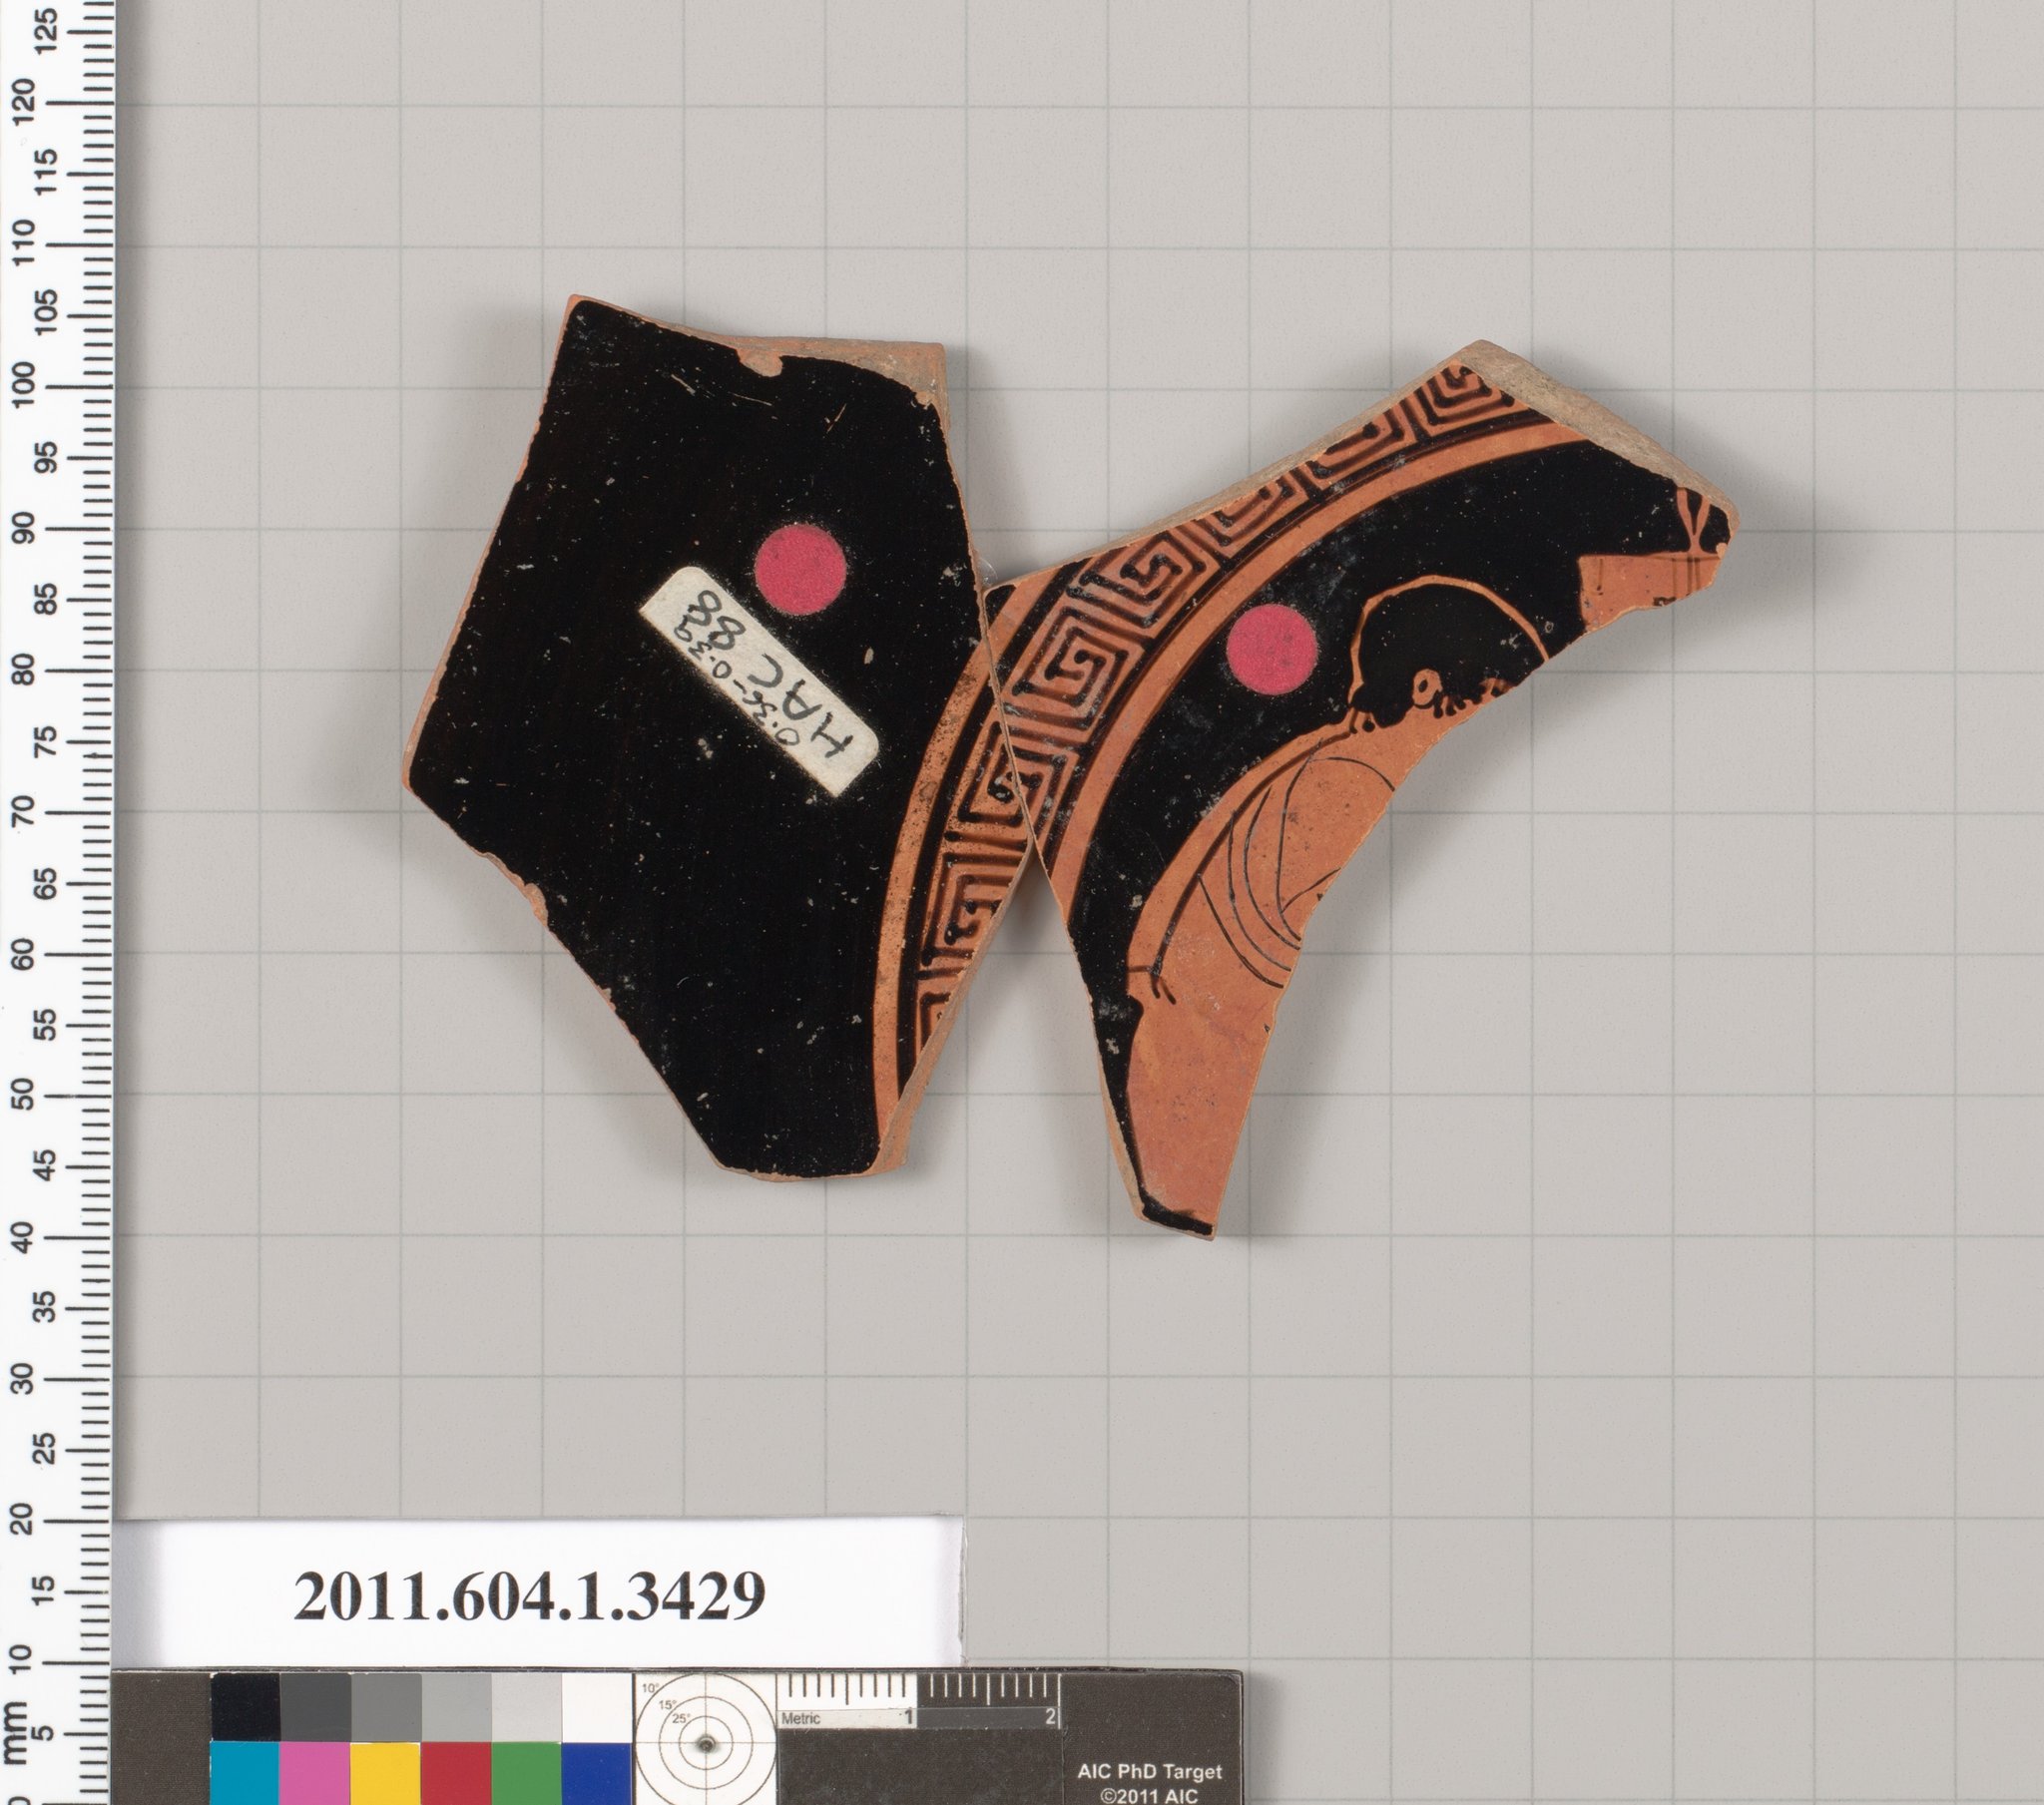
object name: kylix fragment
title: Terracotta fragment of a kylix (drinking cup)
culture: greek, attic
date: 475-451 BCE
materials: terracotta